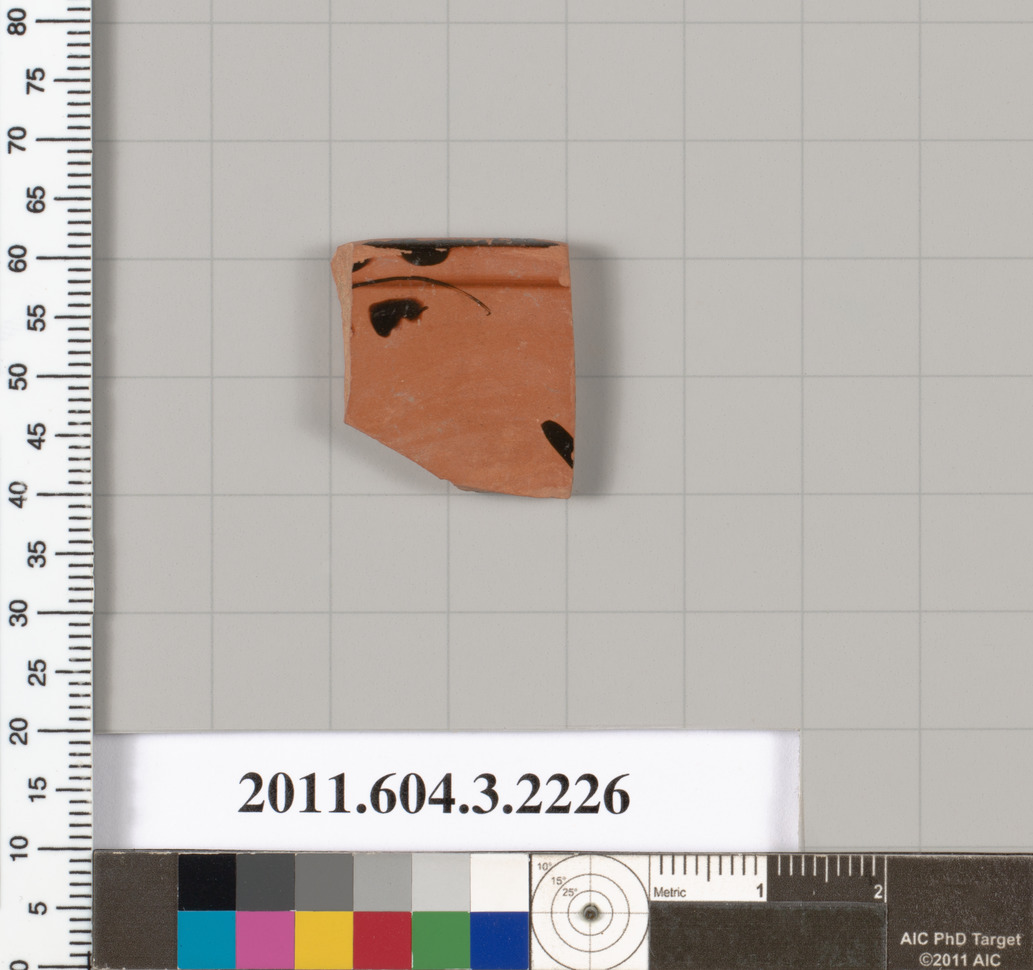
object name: kylix fragment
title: Terracotta fragment of a kylix (drinking cup)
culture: greek, attic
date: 525-501 BCE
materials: terracotta